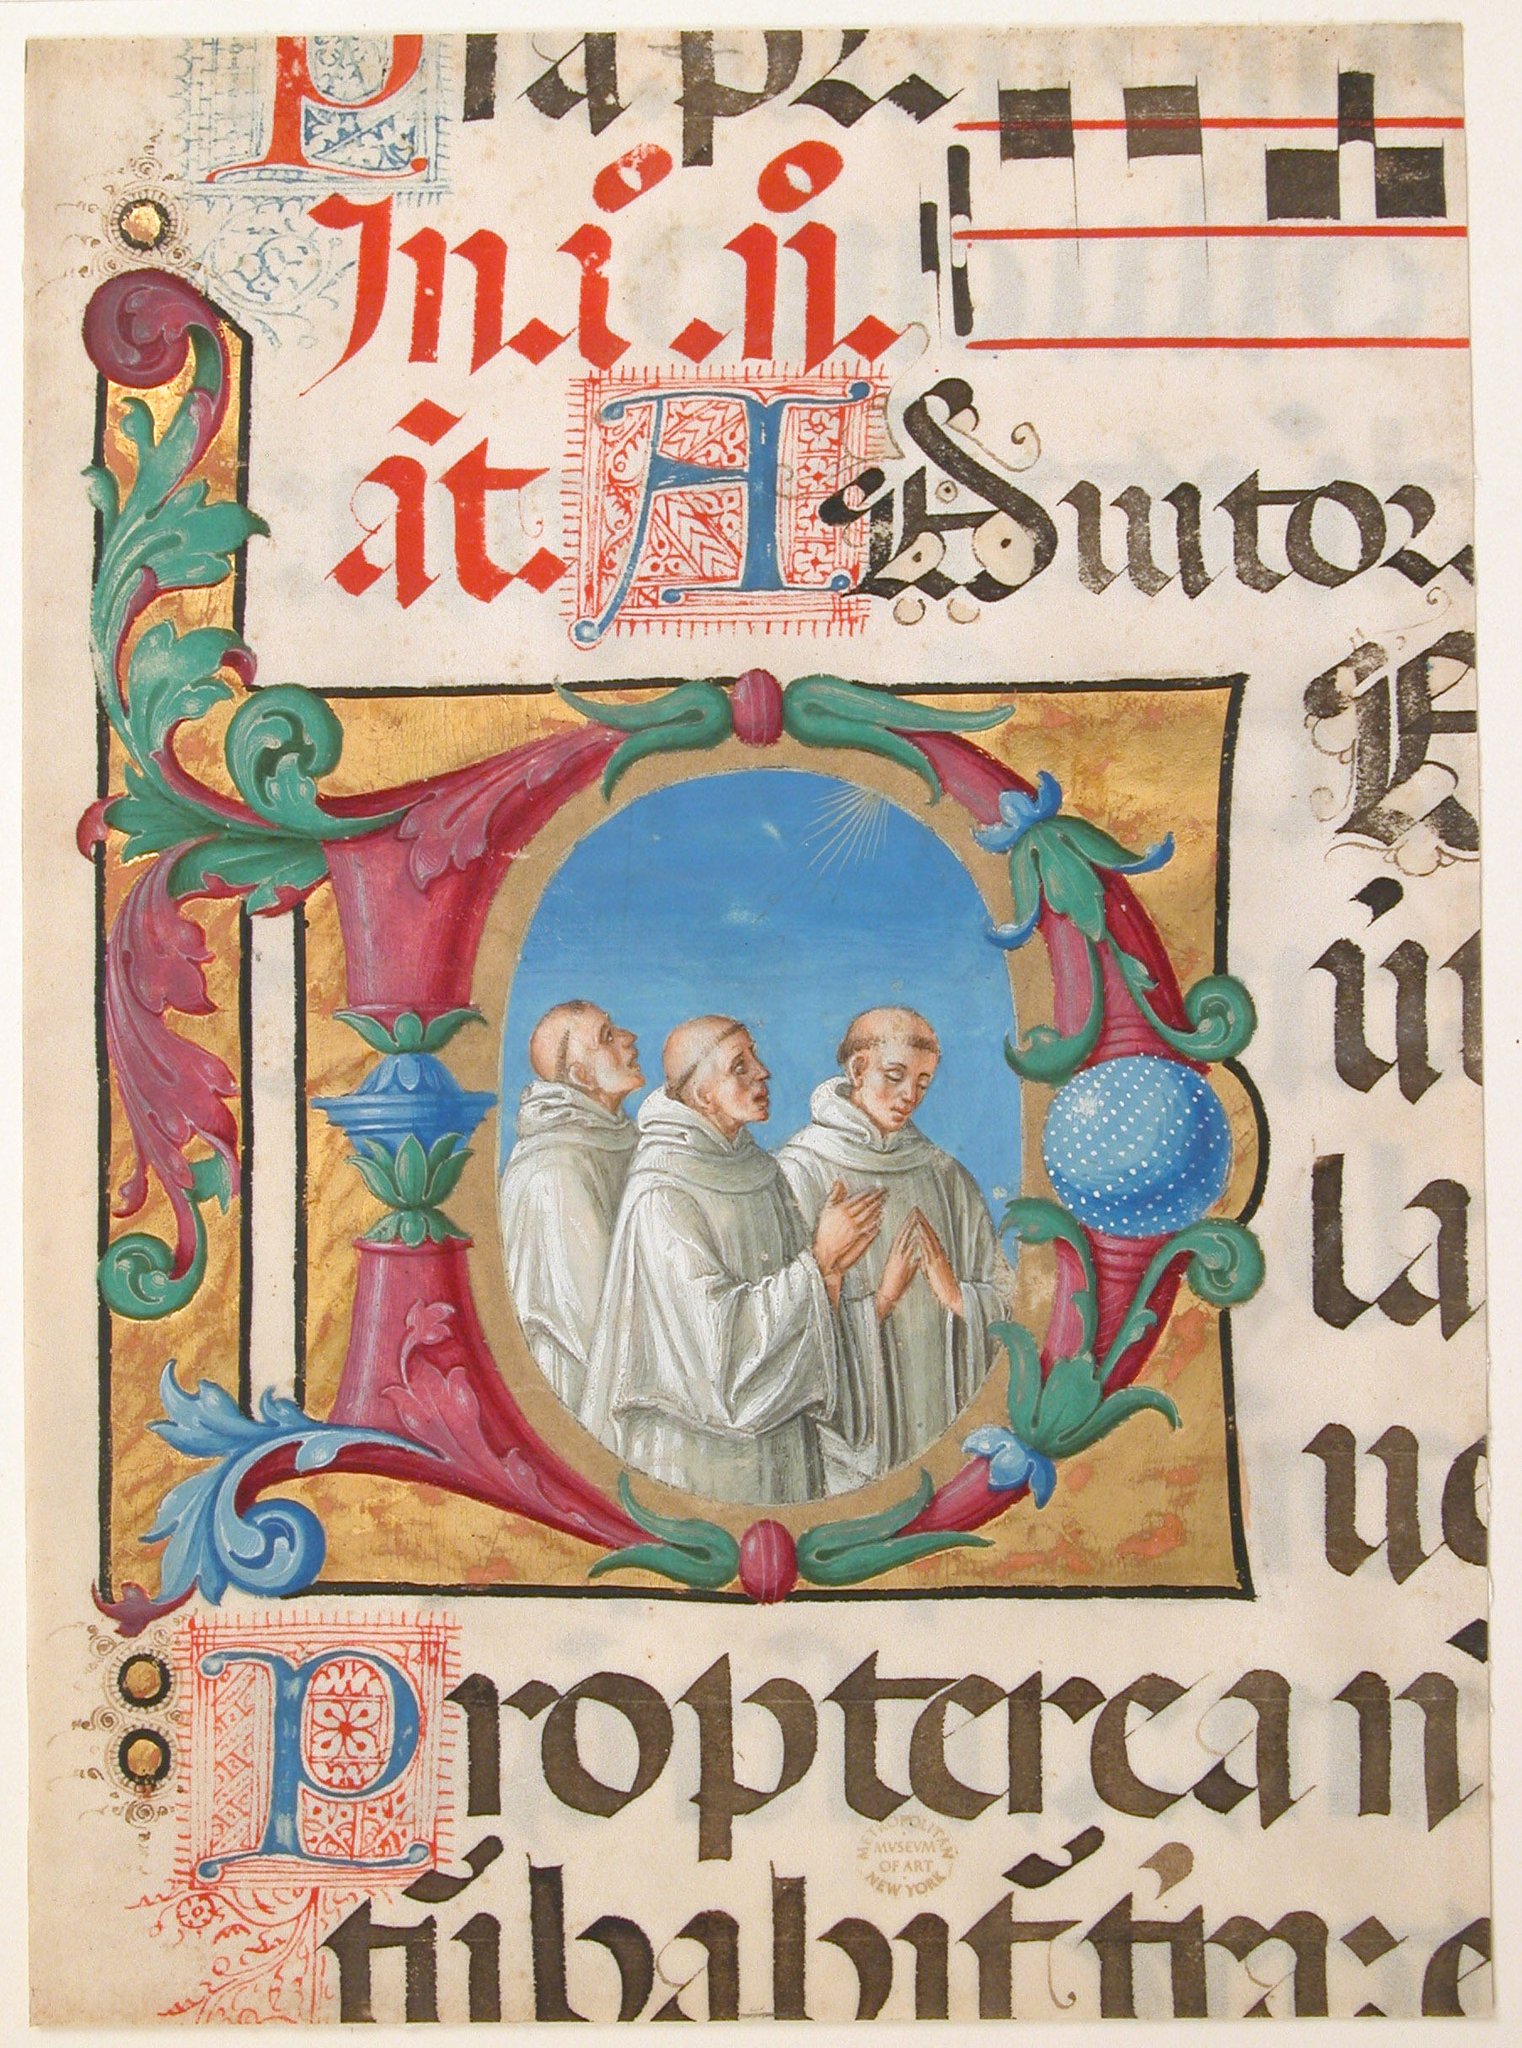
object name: psalter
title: Manuscript Illumination with Singing Monks in an Initial D, from a Psalter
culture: italian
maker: girolamo dai libri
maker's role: artist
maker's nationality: italian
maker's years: 1474-1555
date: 1501-1502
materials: gold, ink, parchment, paint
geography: italy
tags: singing,monks